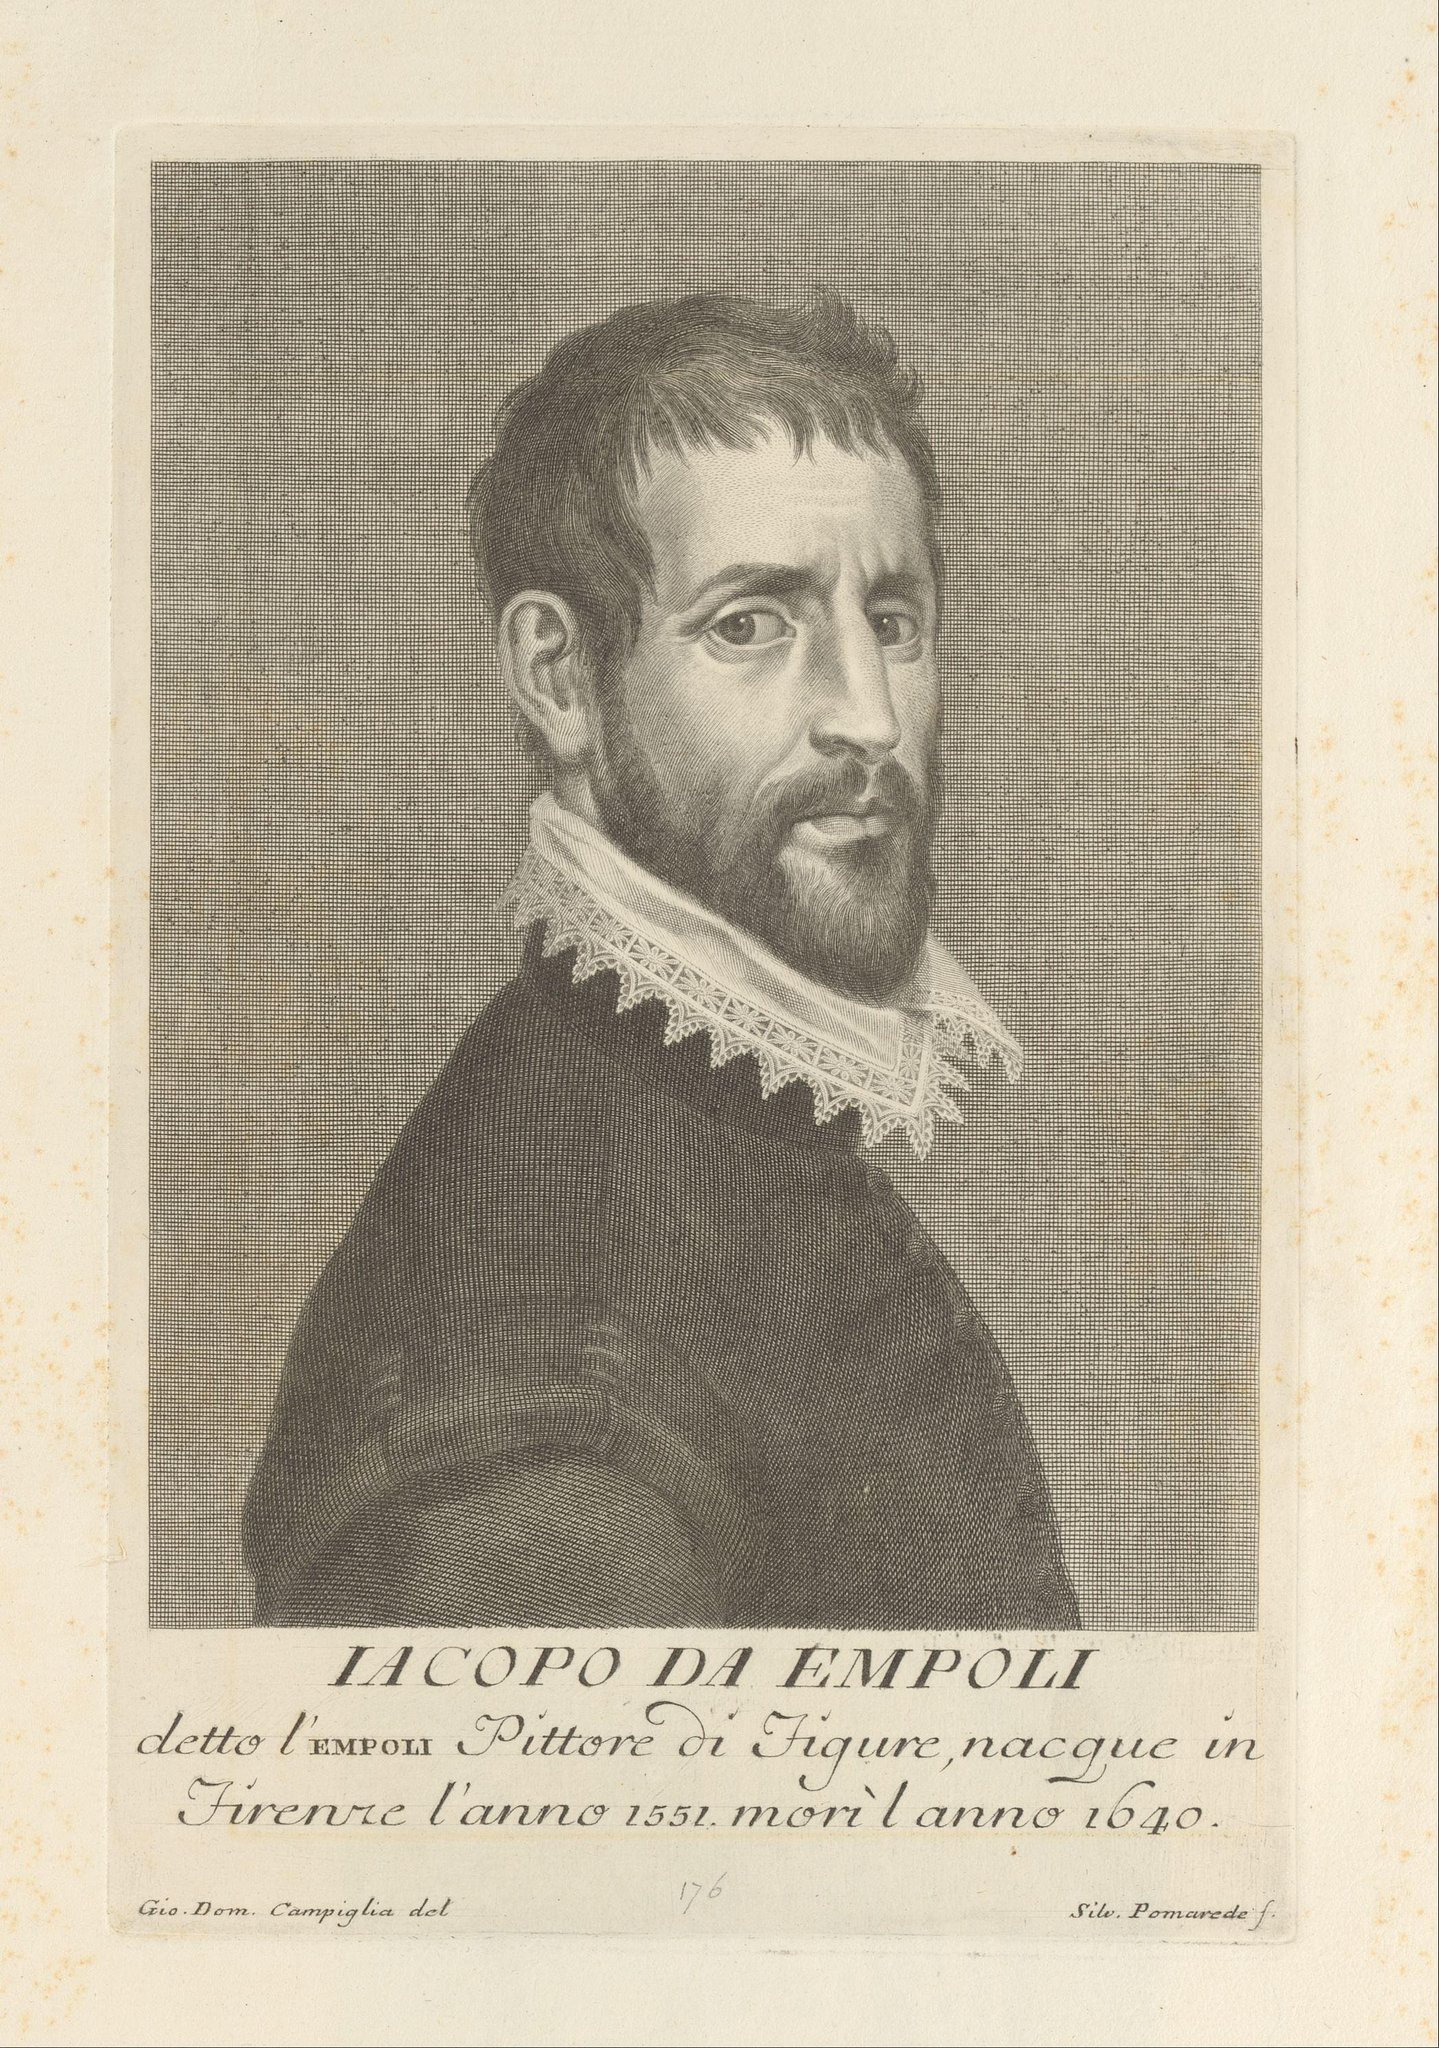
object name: album leaf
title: Iacopo da Empoli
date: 1752-1766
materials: paper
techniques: engraving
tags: painter, jacopo da empoli, historical persons, portrait, self-portrait of painter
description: Prent is onderdeel van een serie getiteld 'Museum Florentinum', bestaande uit vier subsecties: 'Gemmae antiquae ex Thesauro Mediceo et privatorum dactyliothecis florentiae...' (1730-1731), 'Statuae antiquae dorum et virorum illustrium' (1734), 'Antiqua numismata aurea et argentea' (1740-1741) en 'Serie di ritratti degli eccellenti pittori' (1752-1766). Het vierde deel bestaat uit 320 kunstenaarsportretten en is uitgegeven in boekvorm (vier delen). Prent uit: Moücke, Francesco. Serie di ritratti degli eccellenti pittori : dipinti di propria mano che esistono nell'Imperial galleria di Firenze. 4 dln. Florence: Francesco Moücke, 1753, dl. 1, p. 220. De samensteller heeft deze prent in het album gevoegd als illustratie bij: Pilkington, Matthew en Johann Heinrich Füssli. A dictionary of painters, from the revival of the art to the present period. 4 dln. Londen: John Crowder, 1805, dl. 2, p. 176.